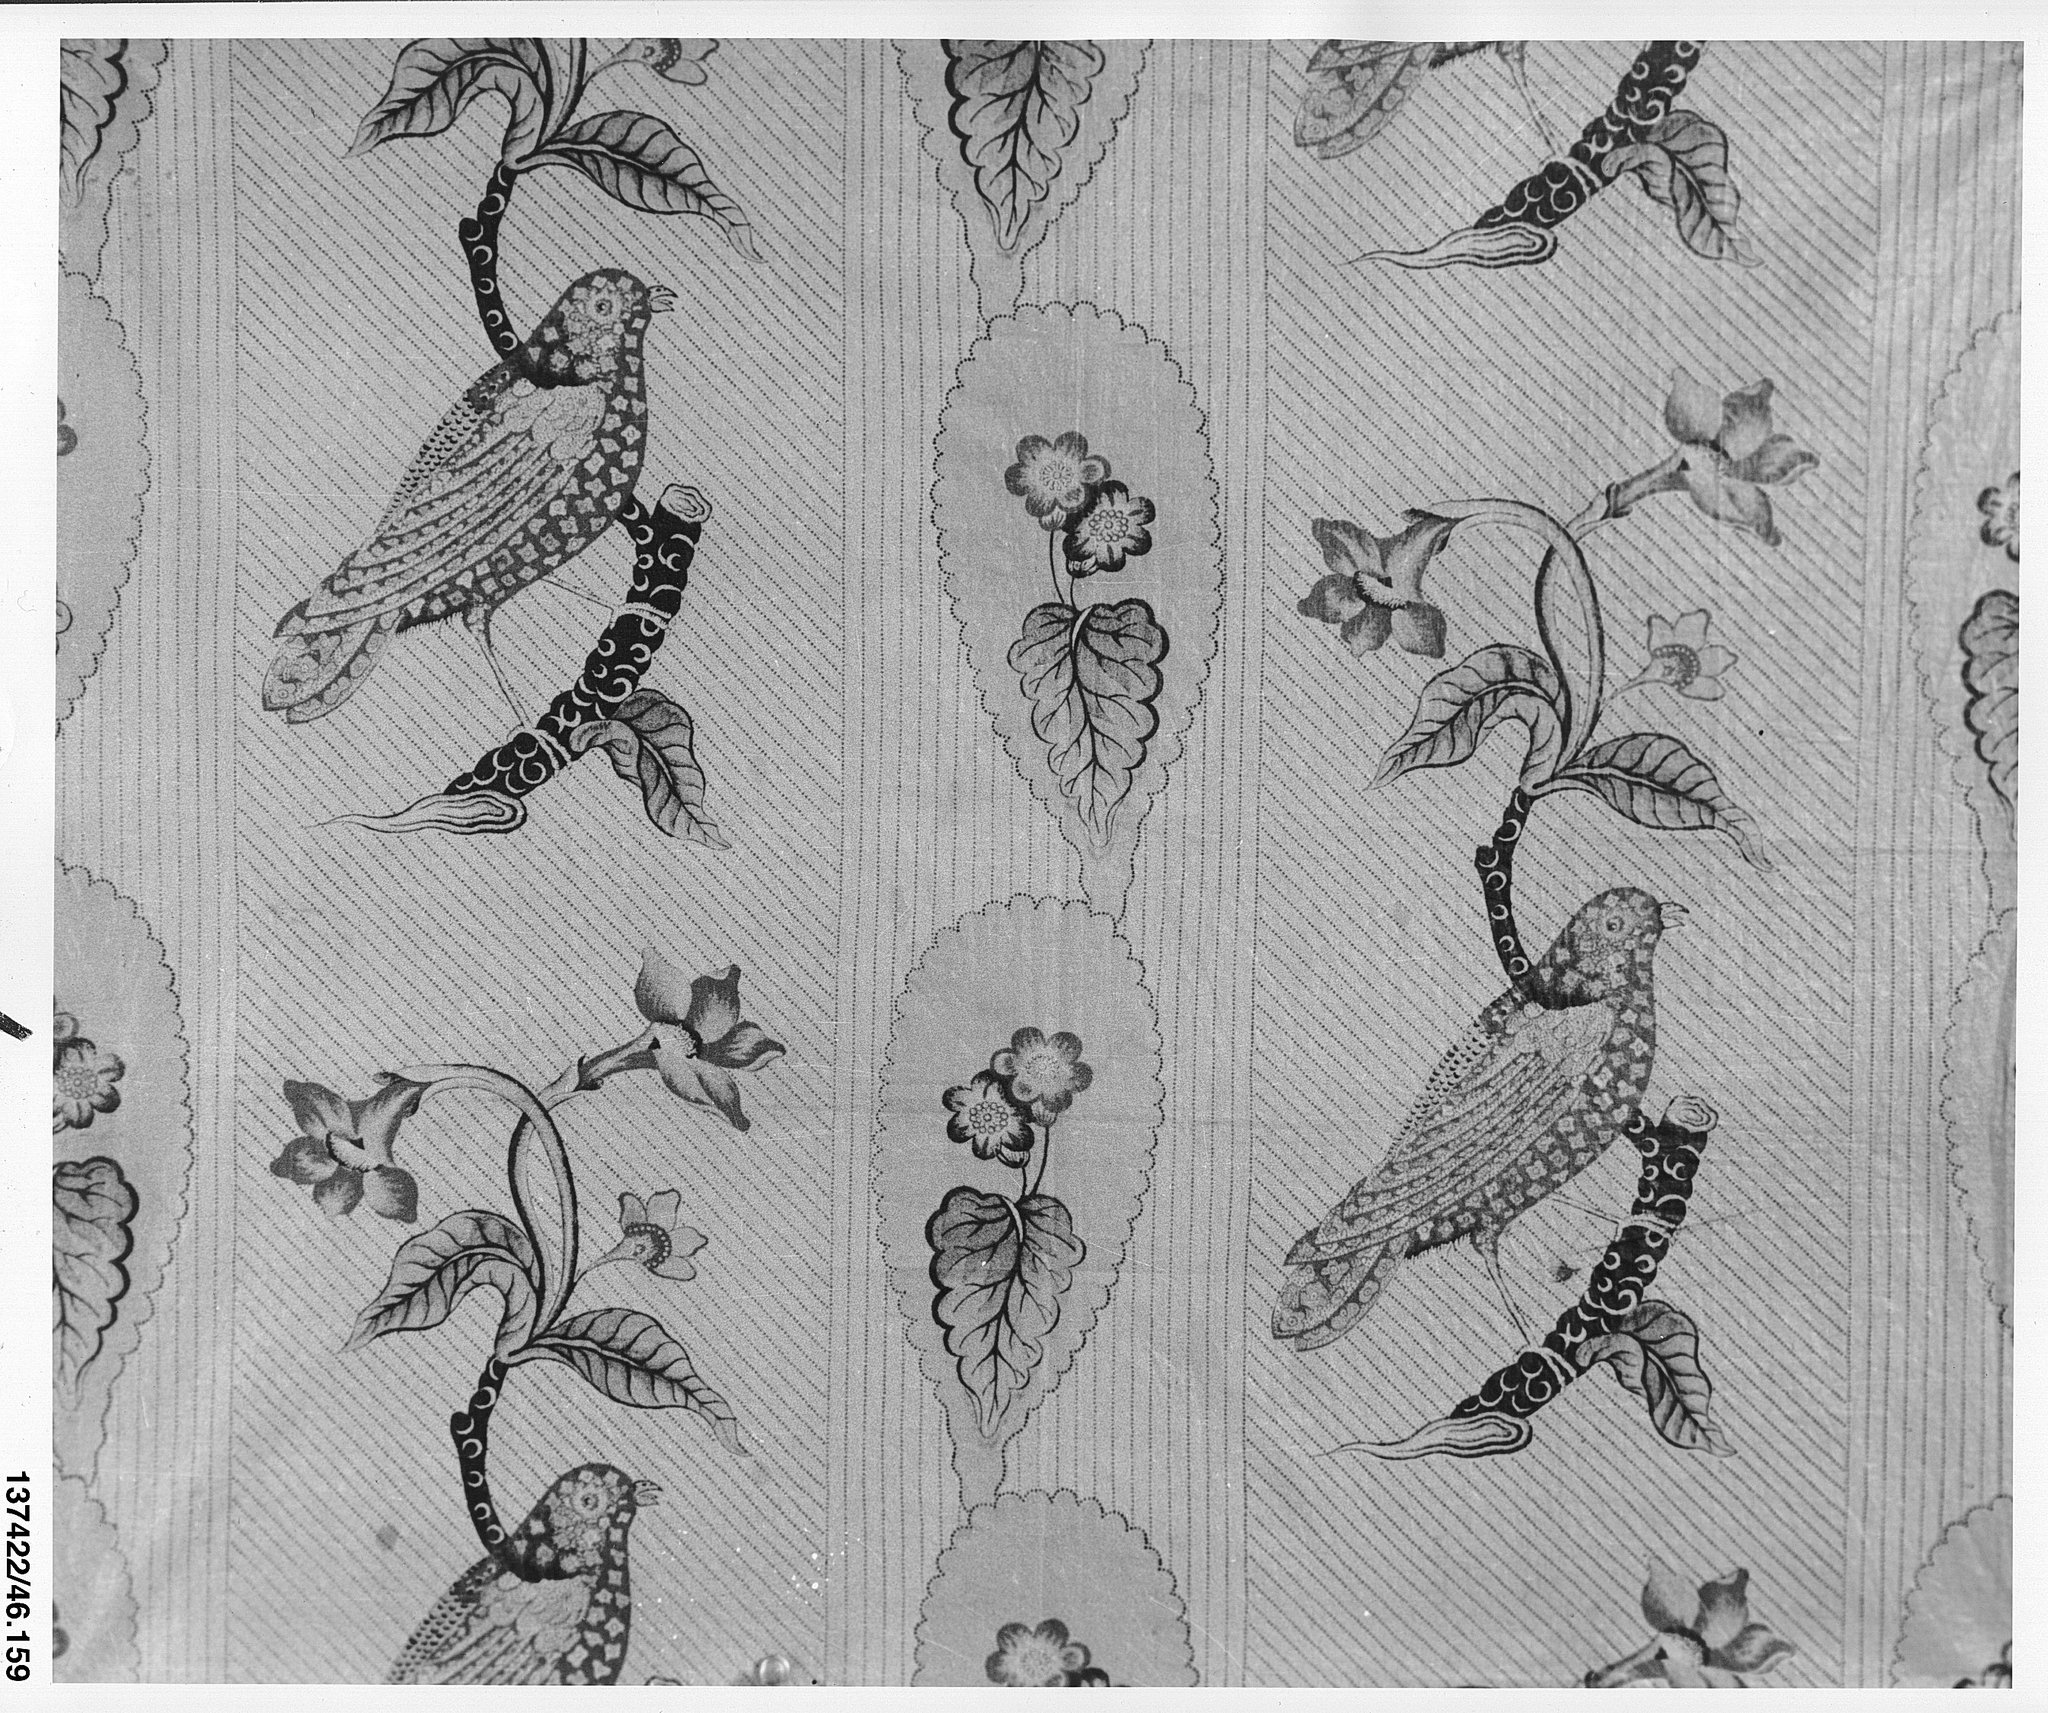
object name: piece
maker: wright and lee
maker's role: manufacturer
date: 1840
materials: cotton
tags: birds,leaves